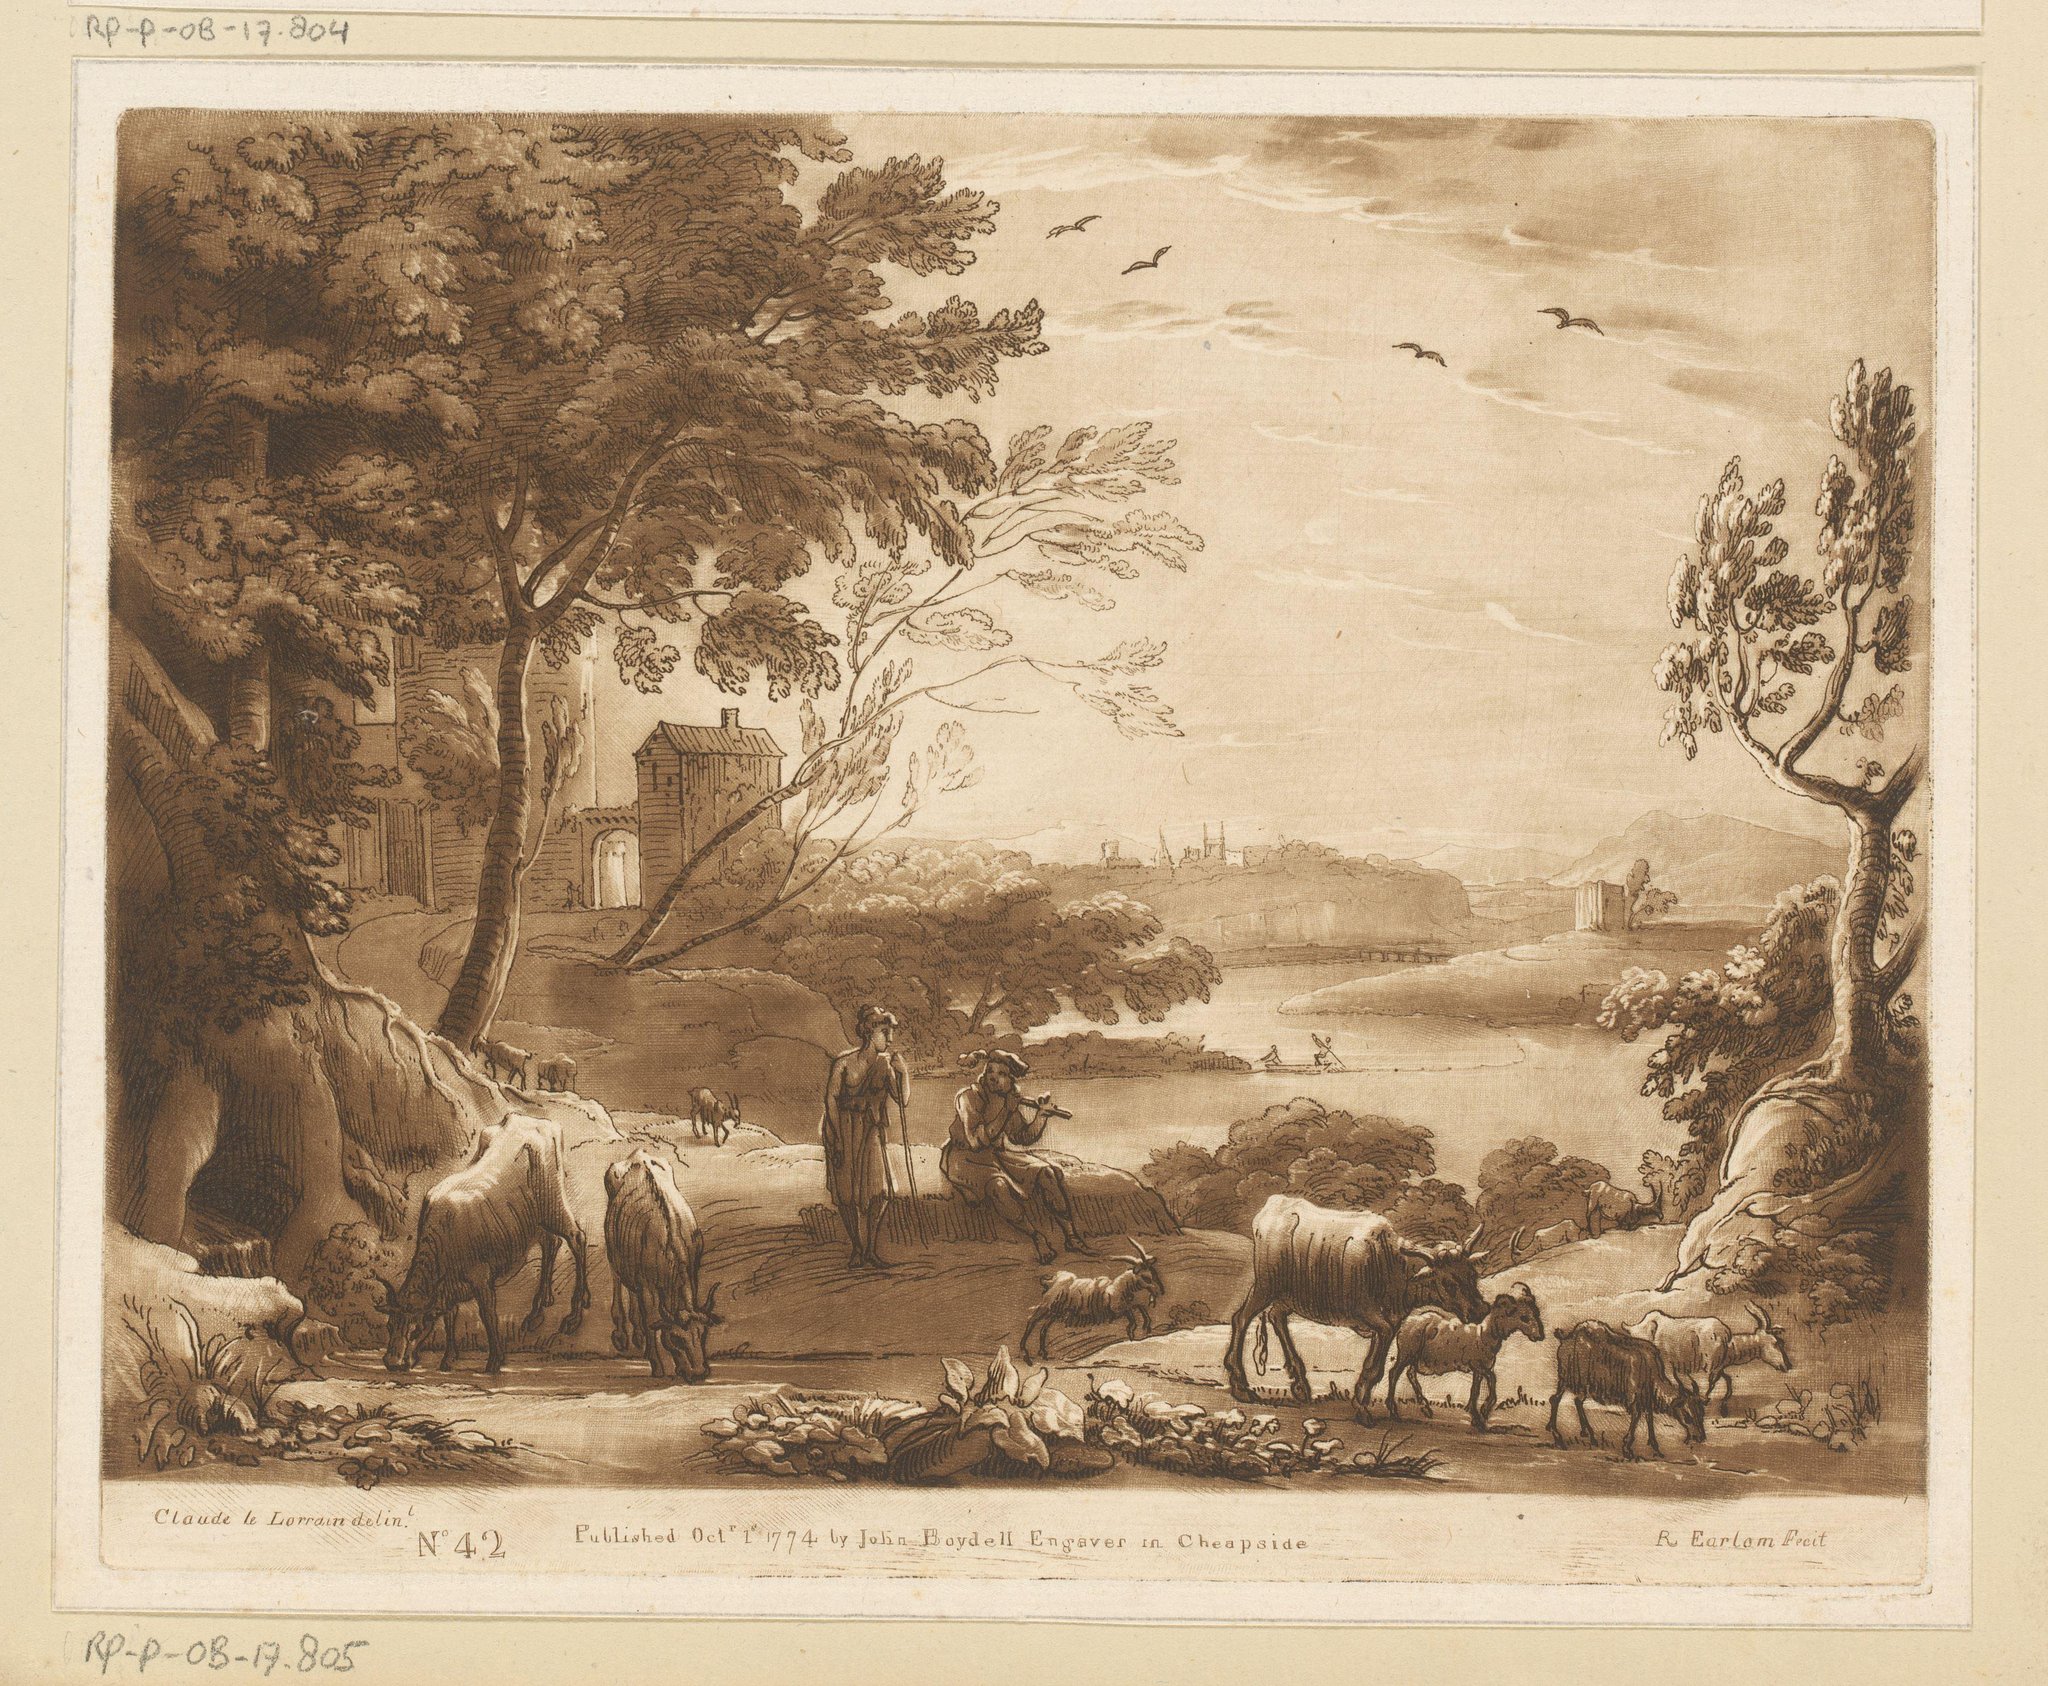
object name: print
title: Liber Veritatis. Or a Collection of Two Hundred Prints, after the original designs of Claude le Lorrain (...)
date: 1774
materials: paper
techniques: etching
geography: london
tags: herding, herdsman, herdswoman, shepherd, shepherdess, cowherd, etc., cattle, lake, flute, aulos, tibia - cc - out of doors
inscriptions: date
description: Vanaf 1774 publiceerde John Boydell tweehonderd prenten naar het tekeningenboek Liber Veritatis van Claude Lorrain, in het bezit van de hertogen van Cavendish. Deze prenten werden vanaf 1777 in twee volumes gebundeld uitgegeven.